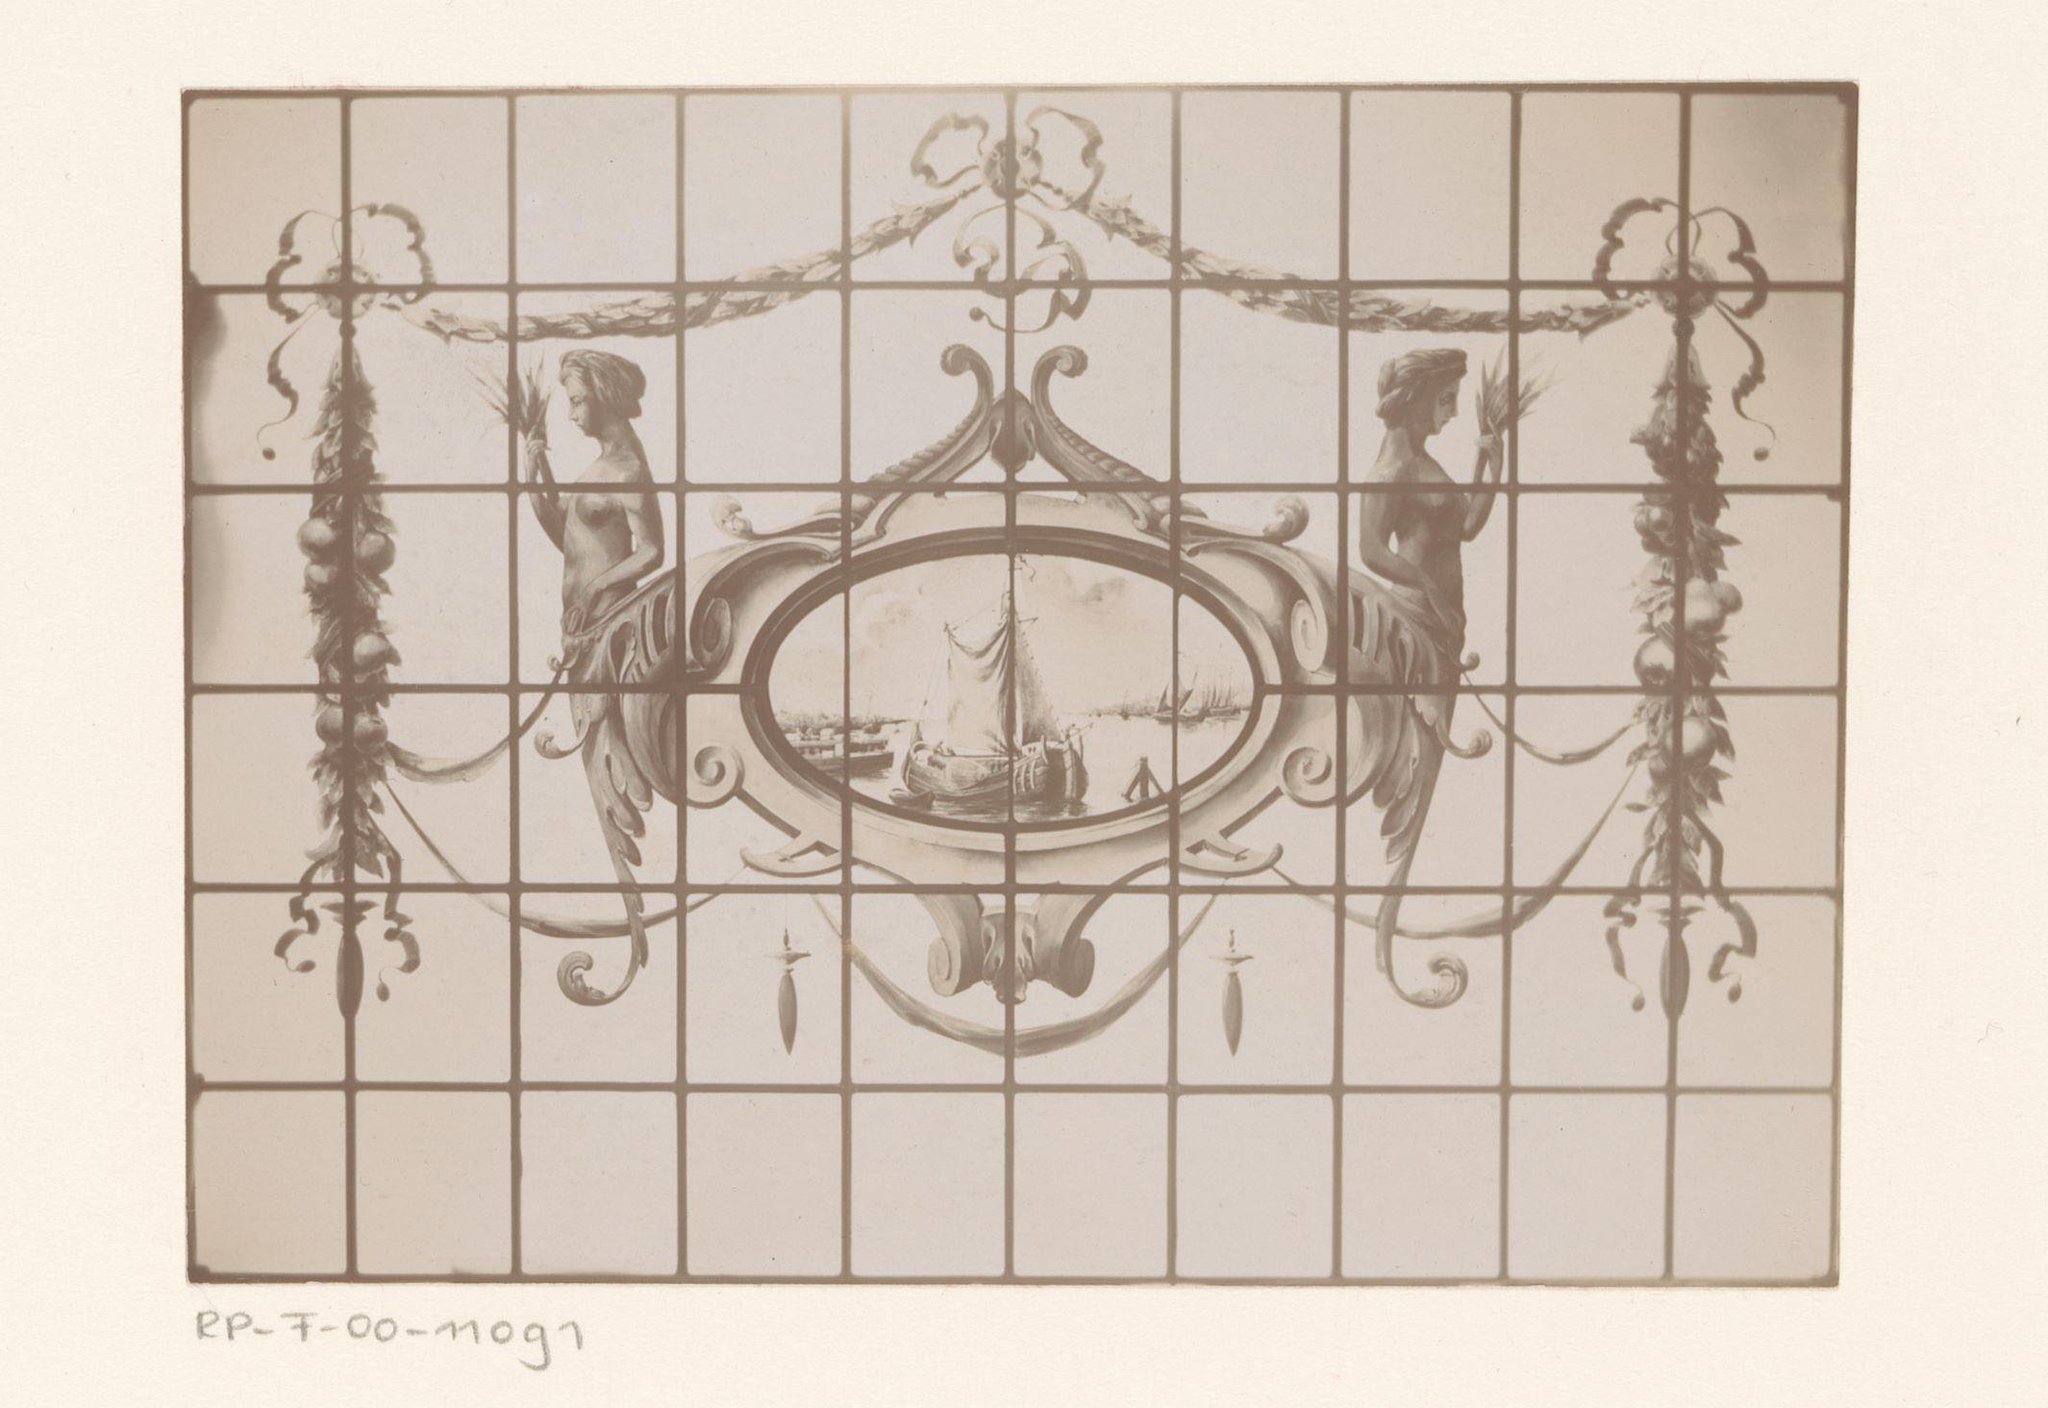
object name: photograph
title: Glas in loodraam met een zeilschip in een cartouche en kariatiden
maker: Anonymous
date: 1907-1930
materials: photographic support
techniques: gelatin silver print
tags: sailing-ship, sailing-boat, ornament ~ cartouche, work of monumental art